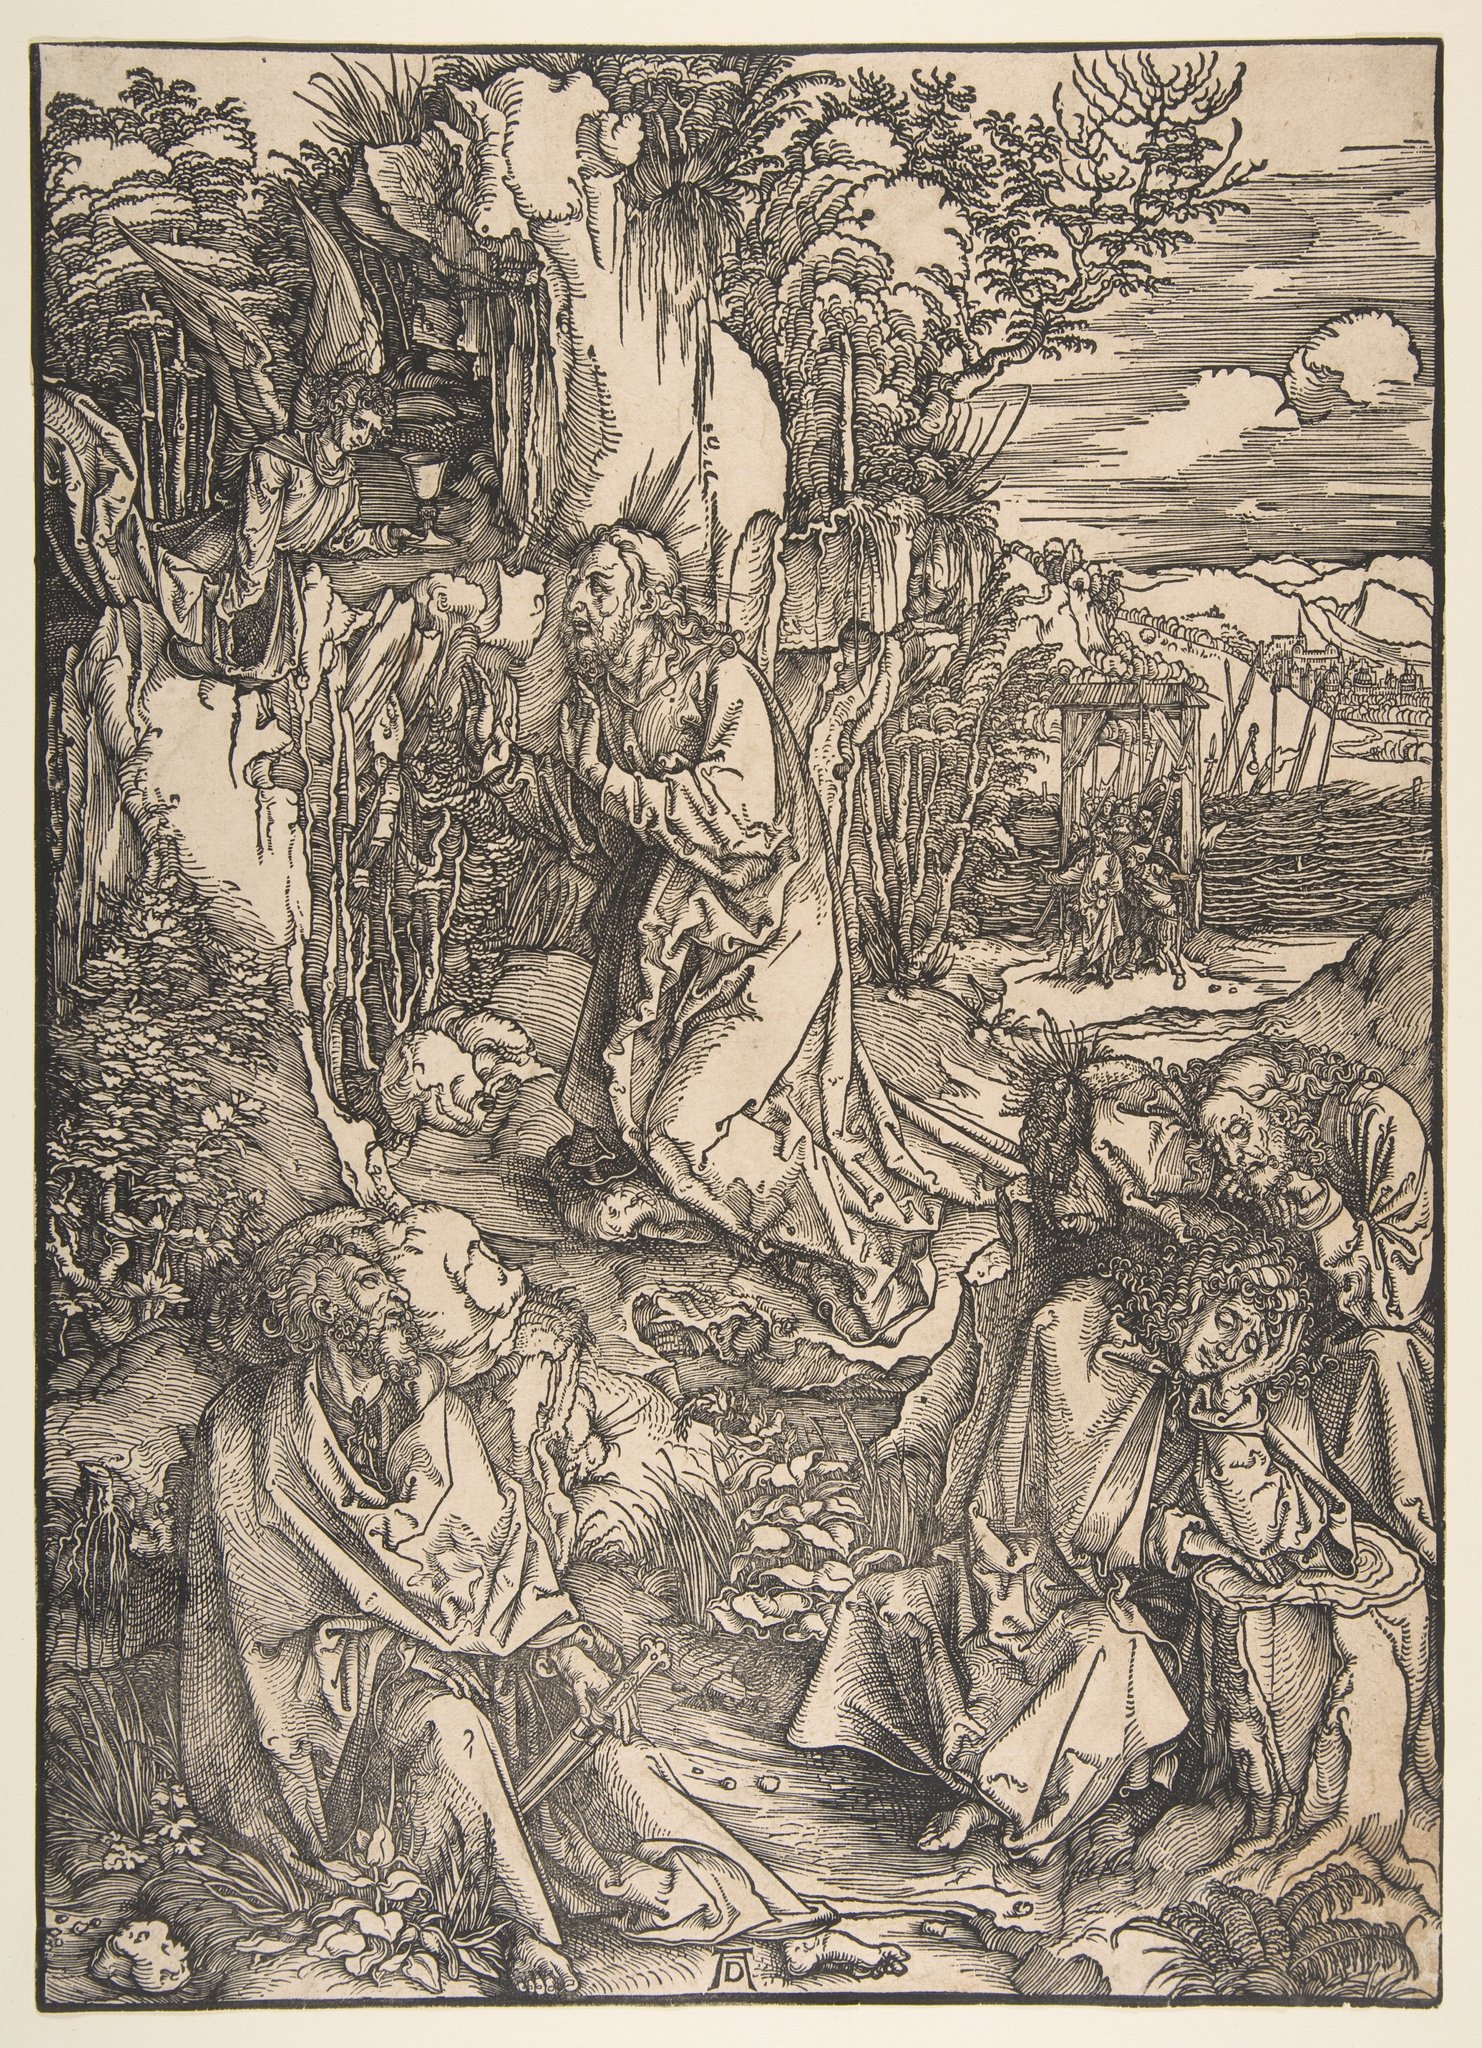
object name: print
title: Agony in the Garden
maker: albrecht dürer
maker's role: artist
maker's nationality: german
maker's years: 1471-1528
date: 1497-1500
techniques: woodcut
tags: gardens,suffering,apostles,christ